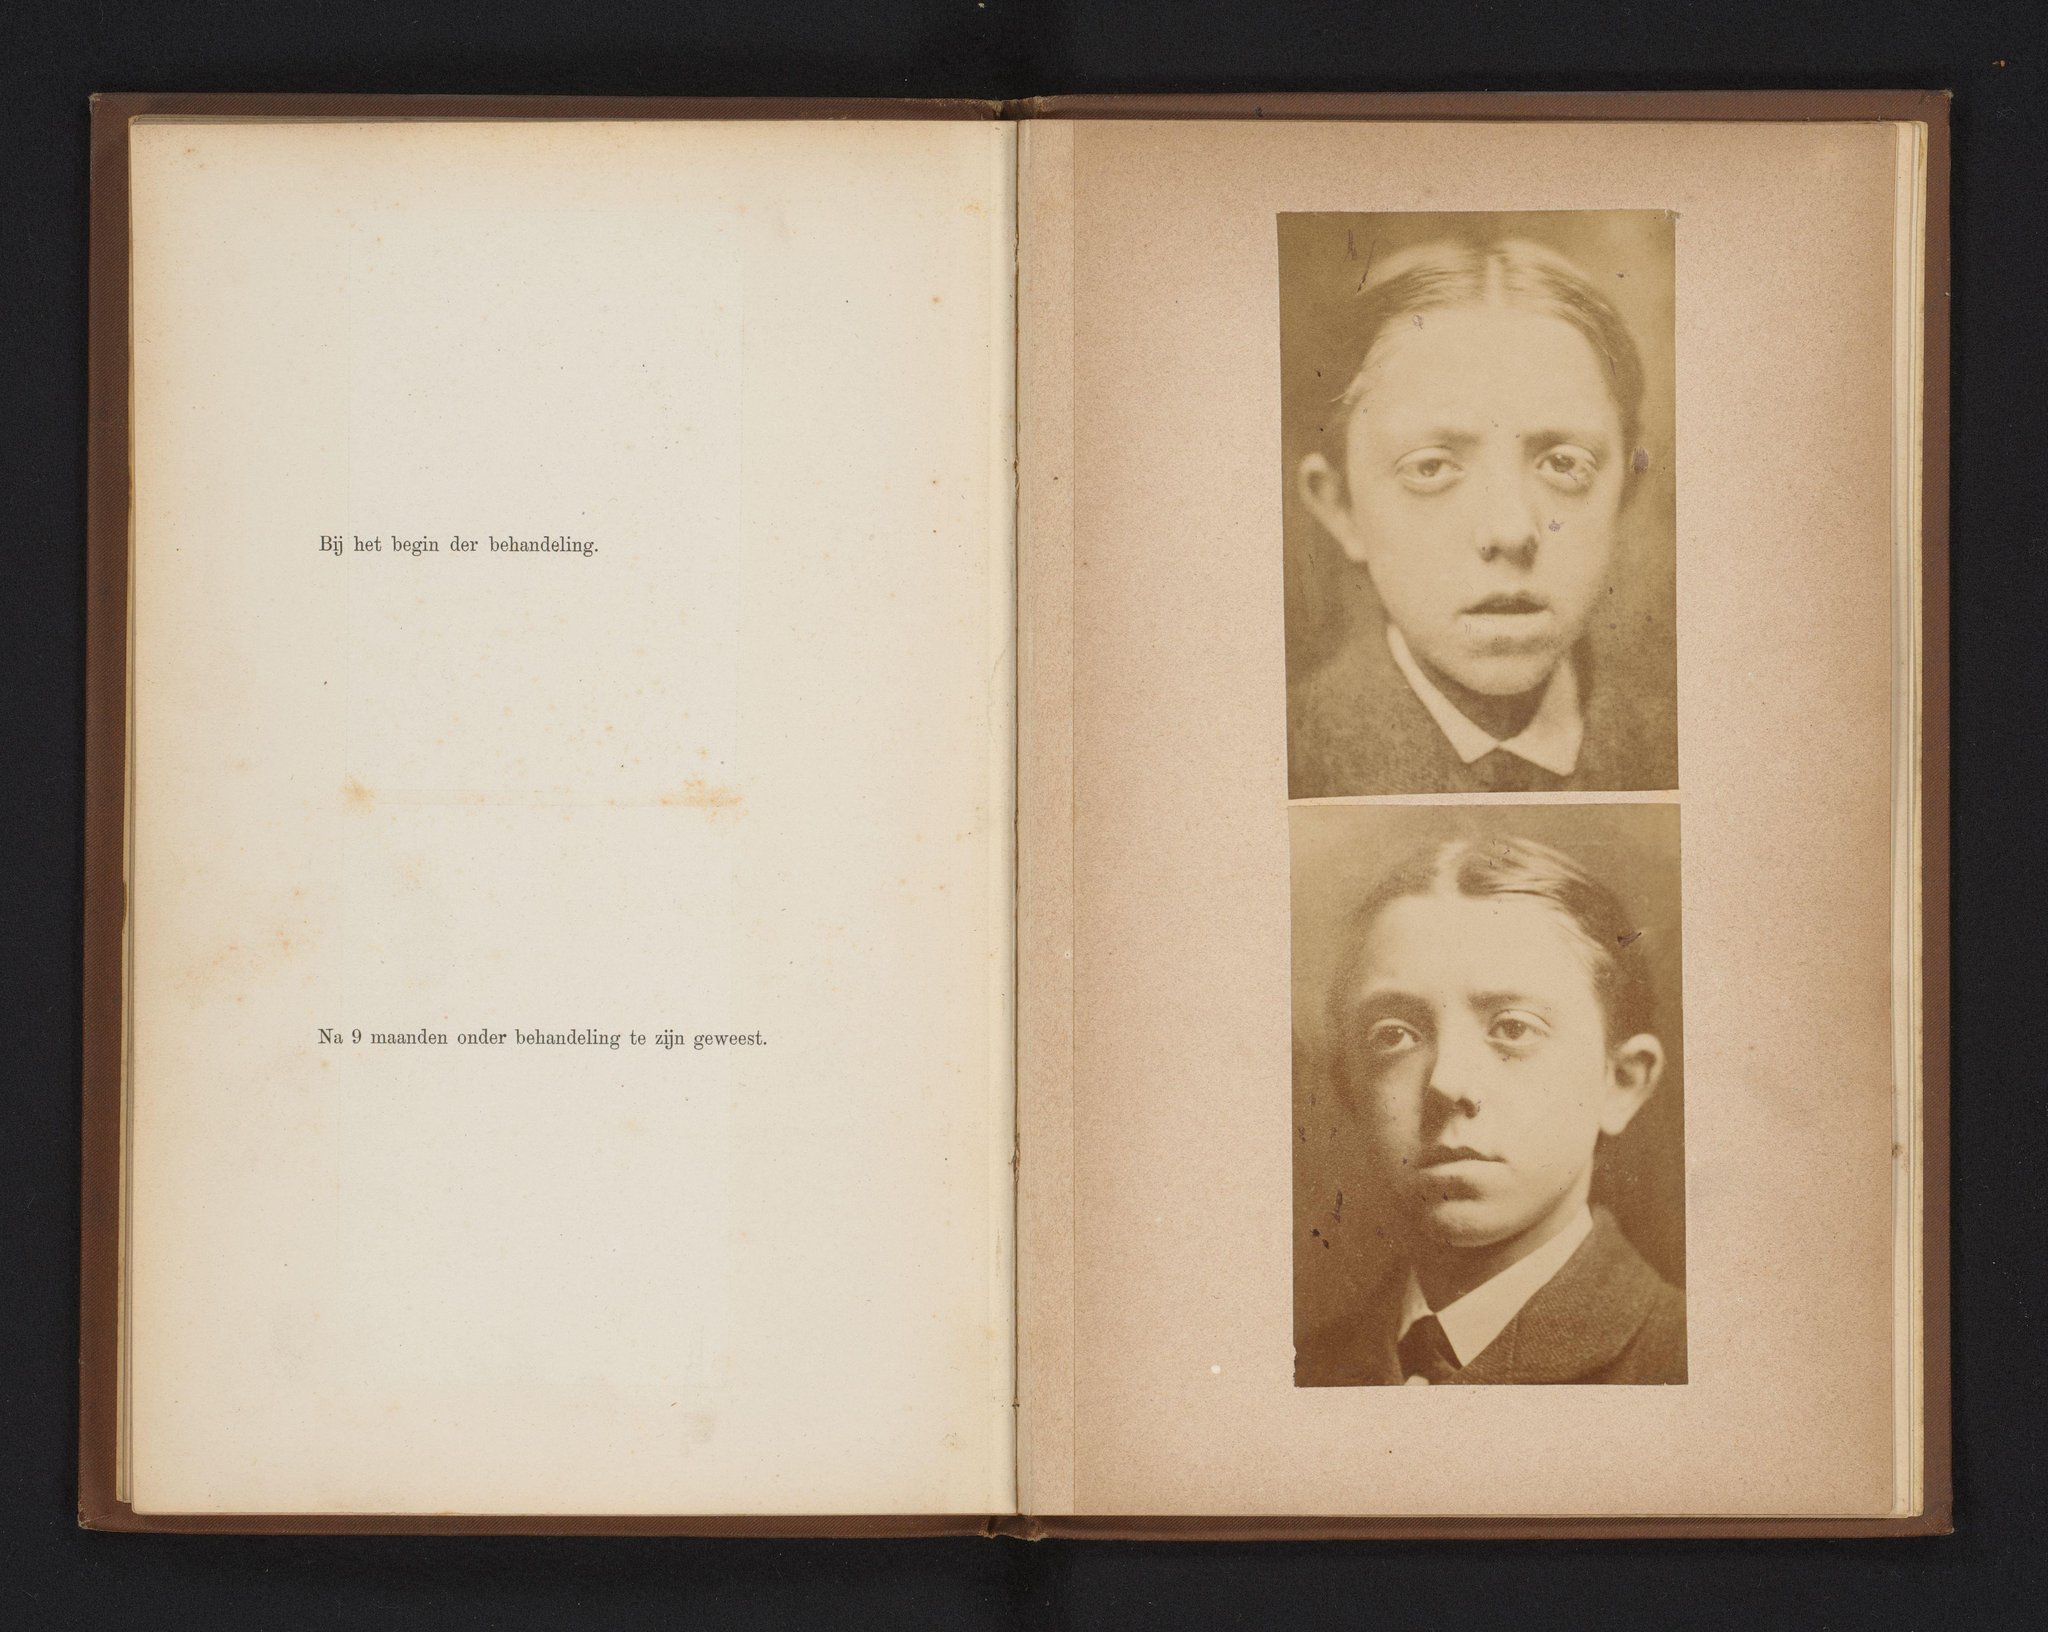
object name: photograph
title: Twee portretten van een onbekende jongen die is behandeld aan zijn neuskeelholte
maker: Anonymous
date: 1880-1881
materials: photographic support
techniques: albumen print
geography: netherlands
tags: boy (child between toddler and youth)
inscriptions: inscription: ‘Bij het begin der behandeling. Na 9 maanden onder behandeling te zijn geweest.’